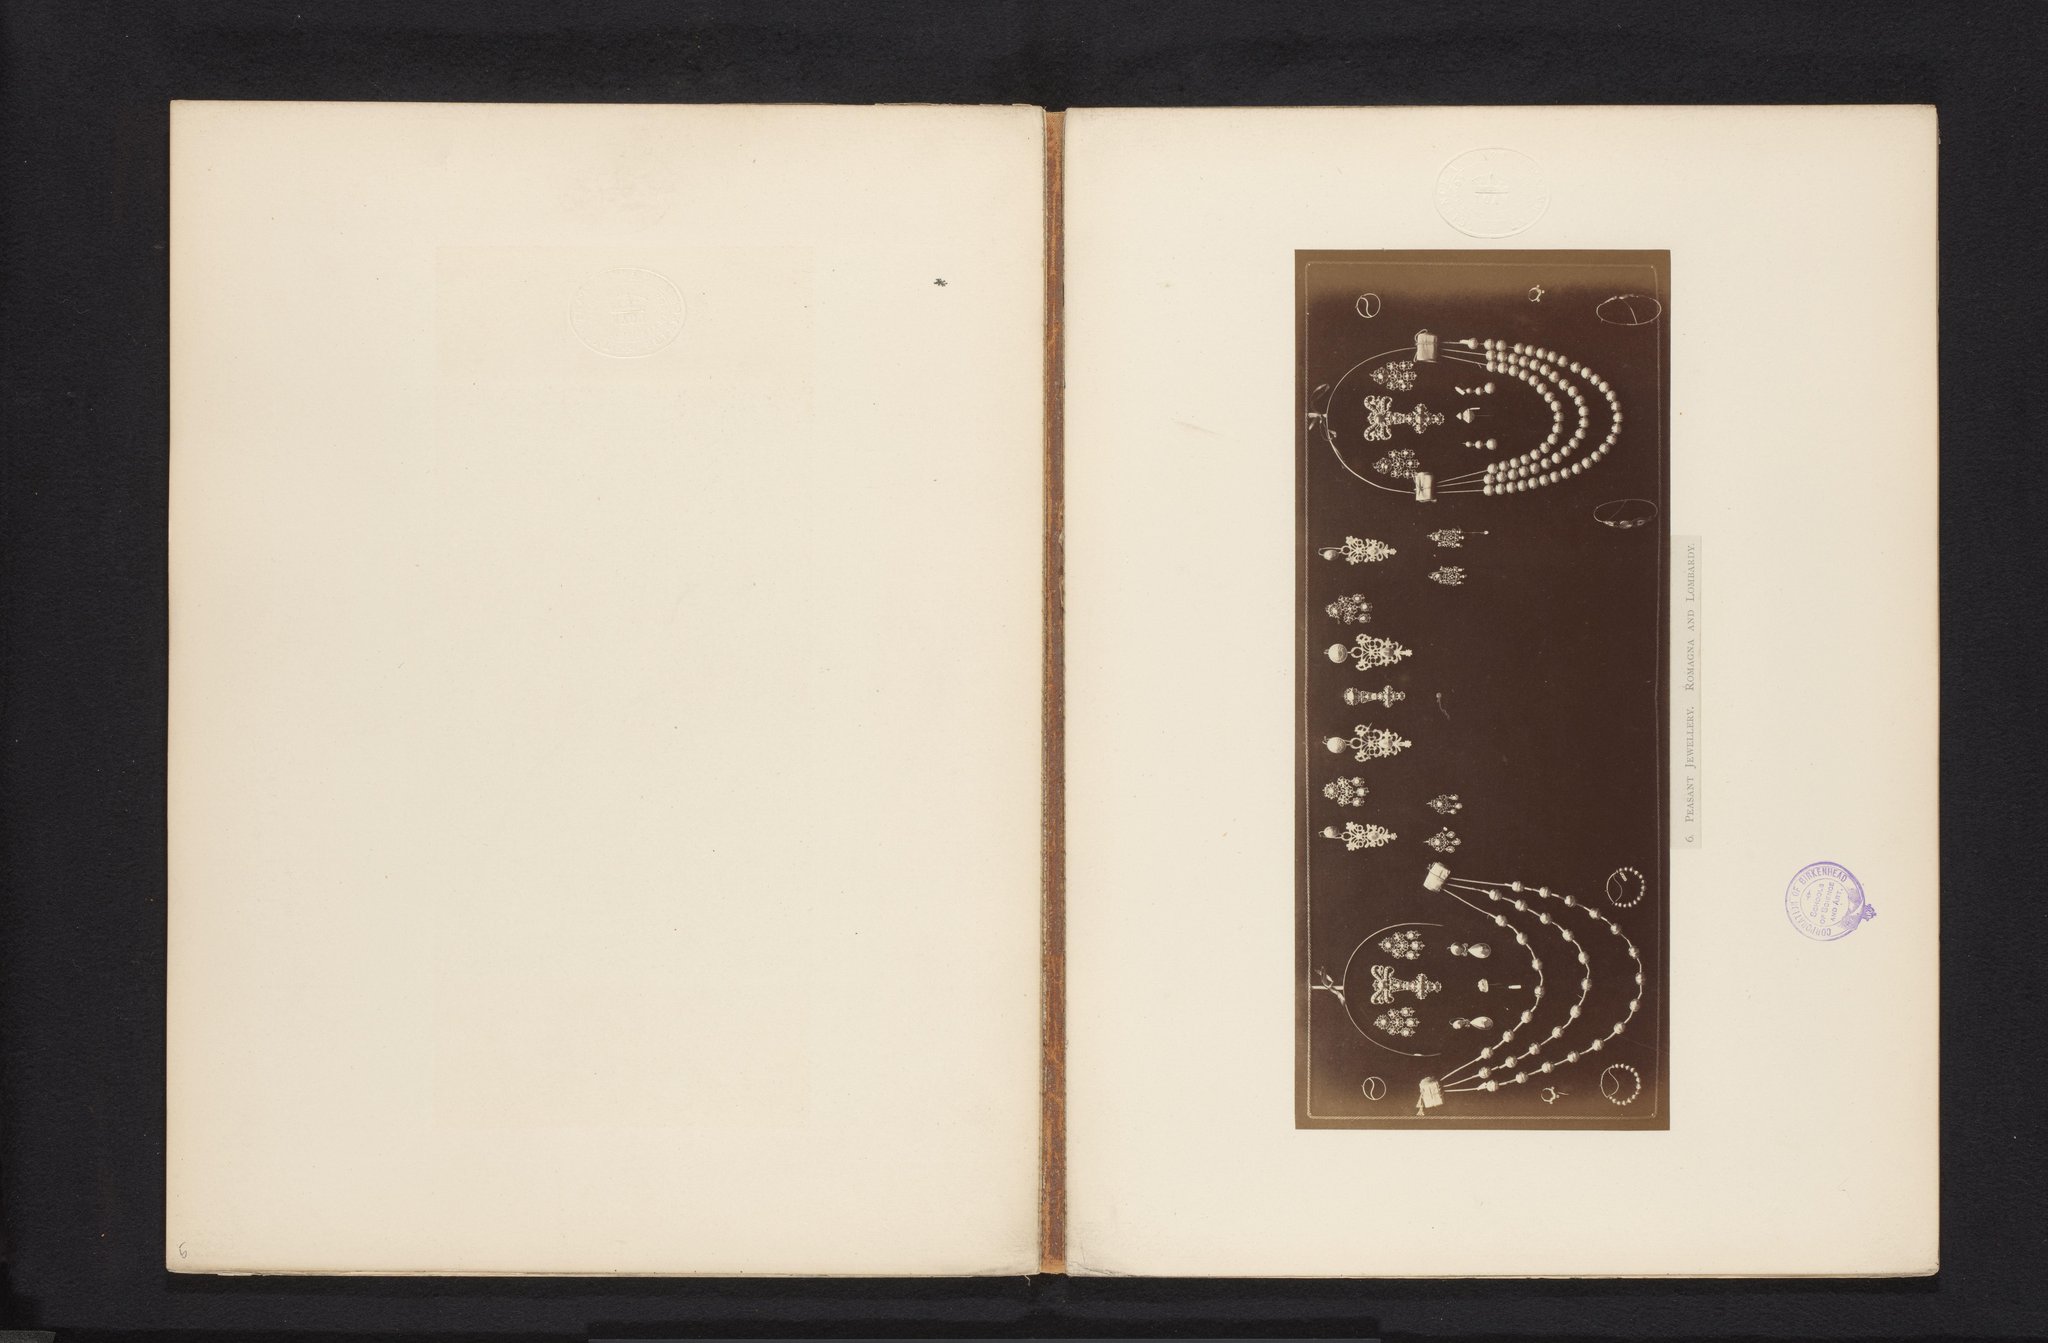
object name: photograph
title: Sieraden uit Lombardije en het voormalige Romagna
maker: Anonymous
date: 1863-1868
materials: photographic support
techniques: albumen print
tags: ornaments, jewels, necklace, ear-rings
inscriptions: collector's mark: ‘Corporation of Birkenhead/ schools of science and art’, collector's mark: ‘South Kensington/ Science and art department’